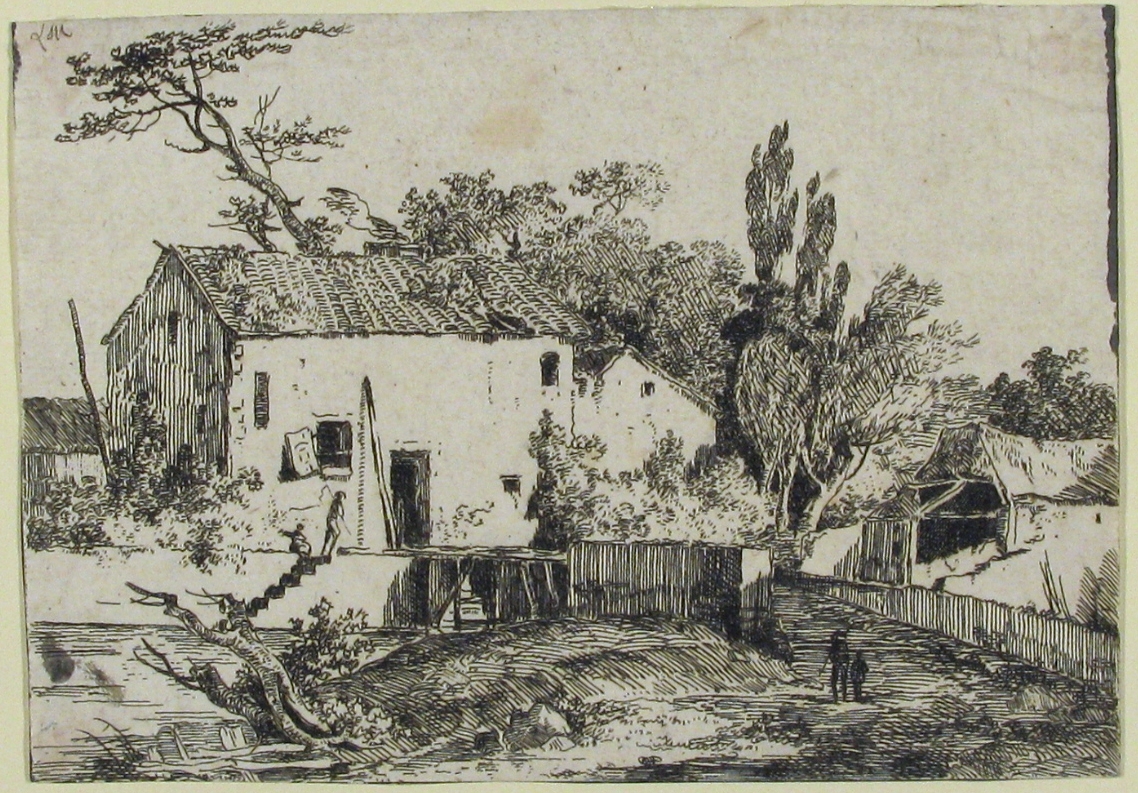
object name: print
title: The Pole Leaning Against the House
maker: louis gabriel moreau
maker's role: artist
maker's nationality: french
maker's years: 1740-1806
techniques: etching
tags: houses